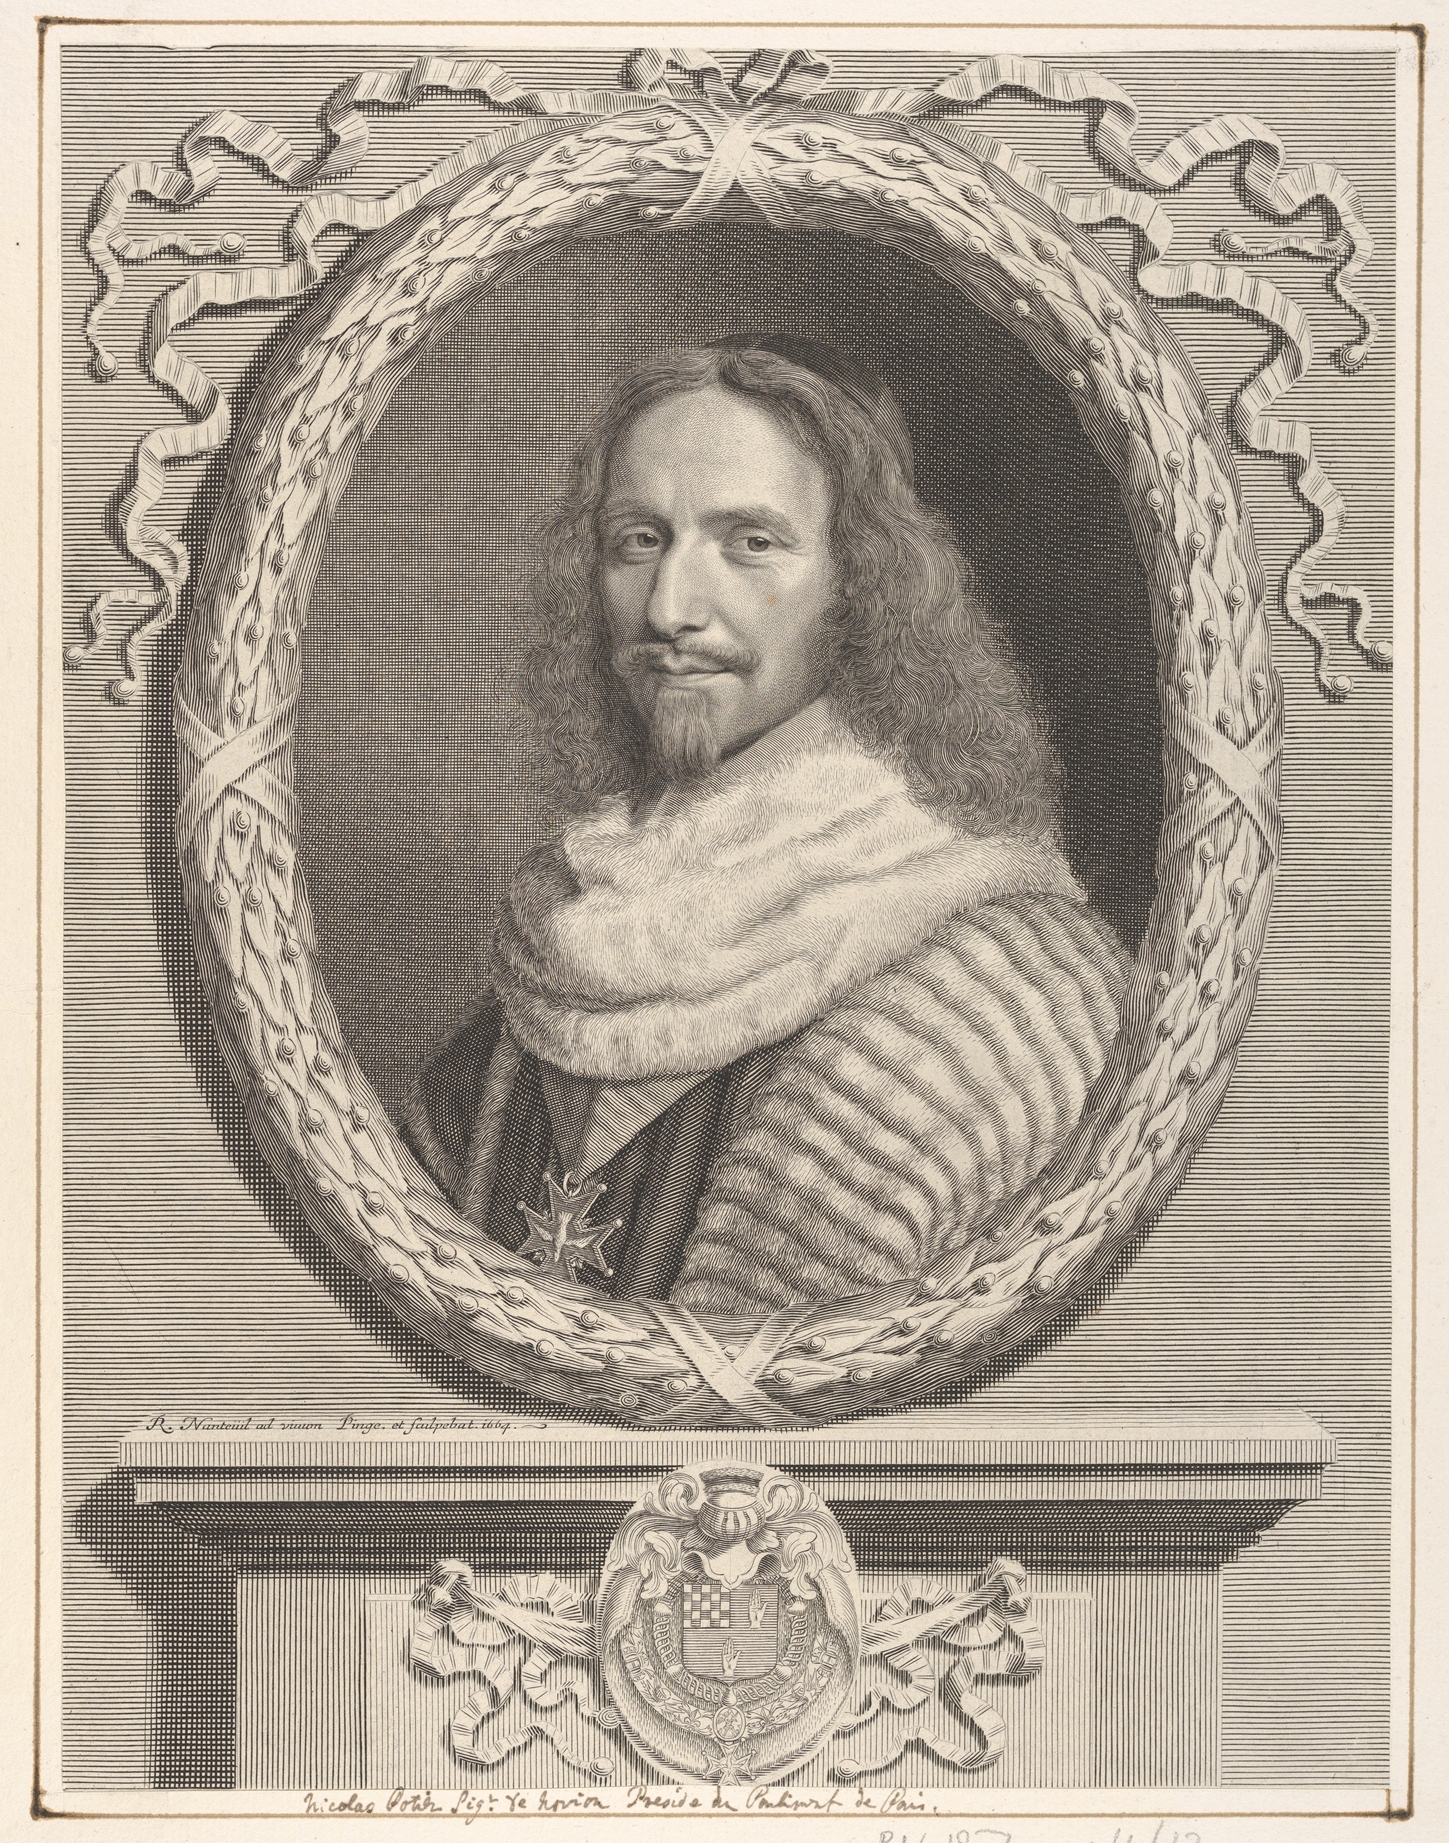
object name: print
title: Nicolas Potier de Novion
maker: robert nanteuil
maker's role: artist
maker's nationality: french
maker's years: 1623-1678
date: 1664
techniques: engraving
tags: men,portraits